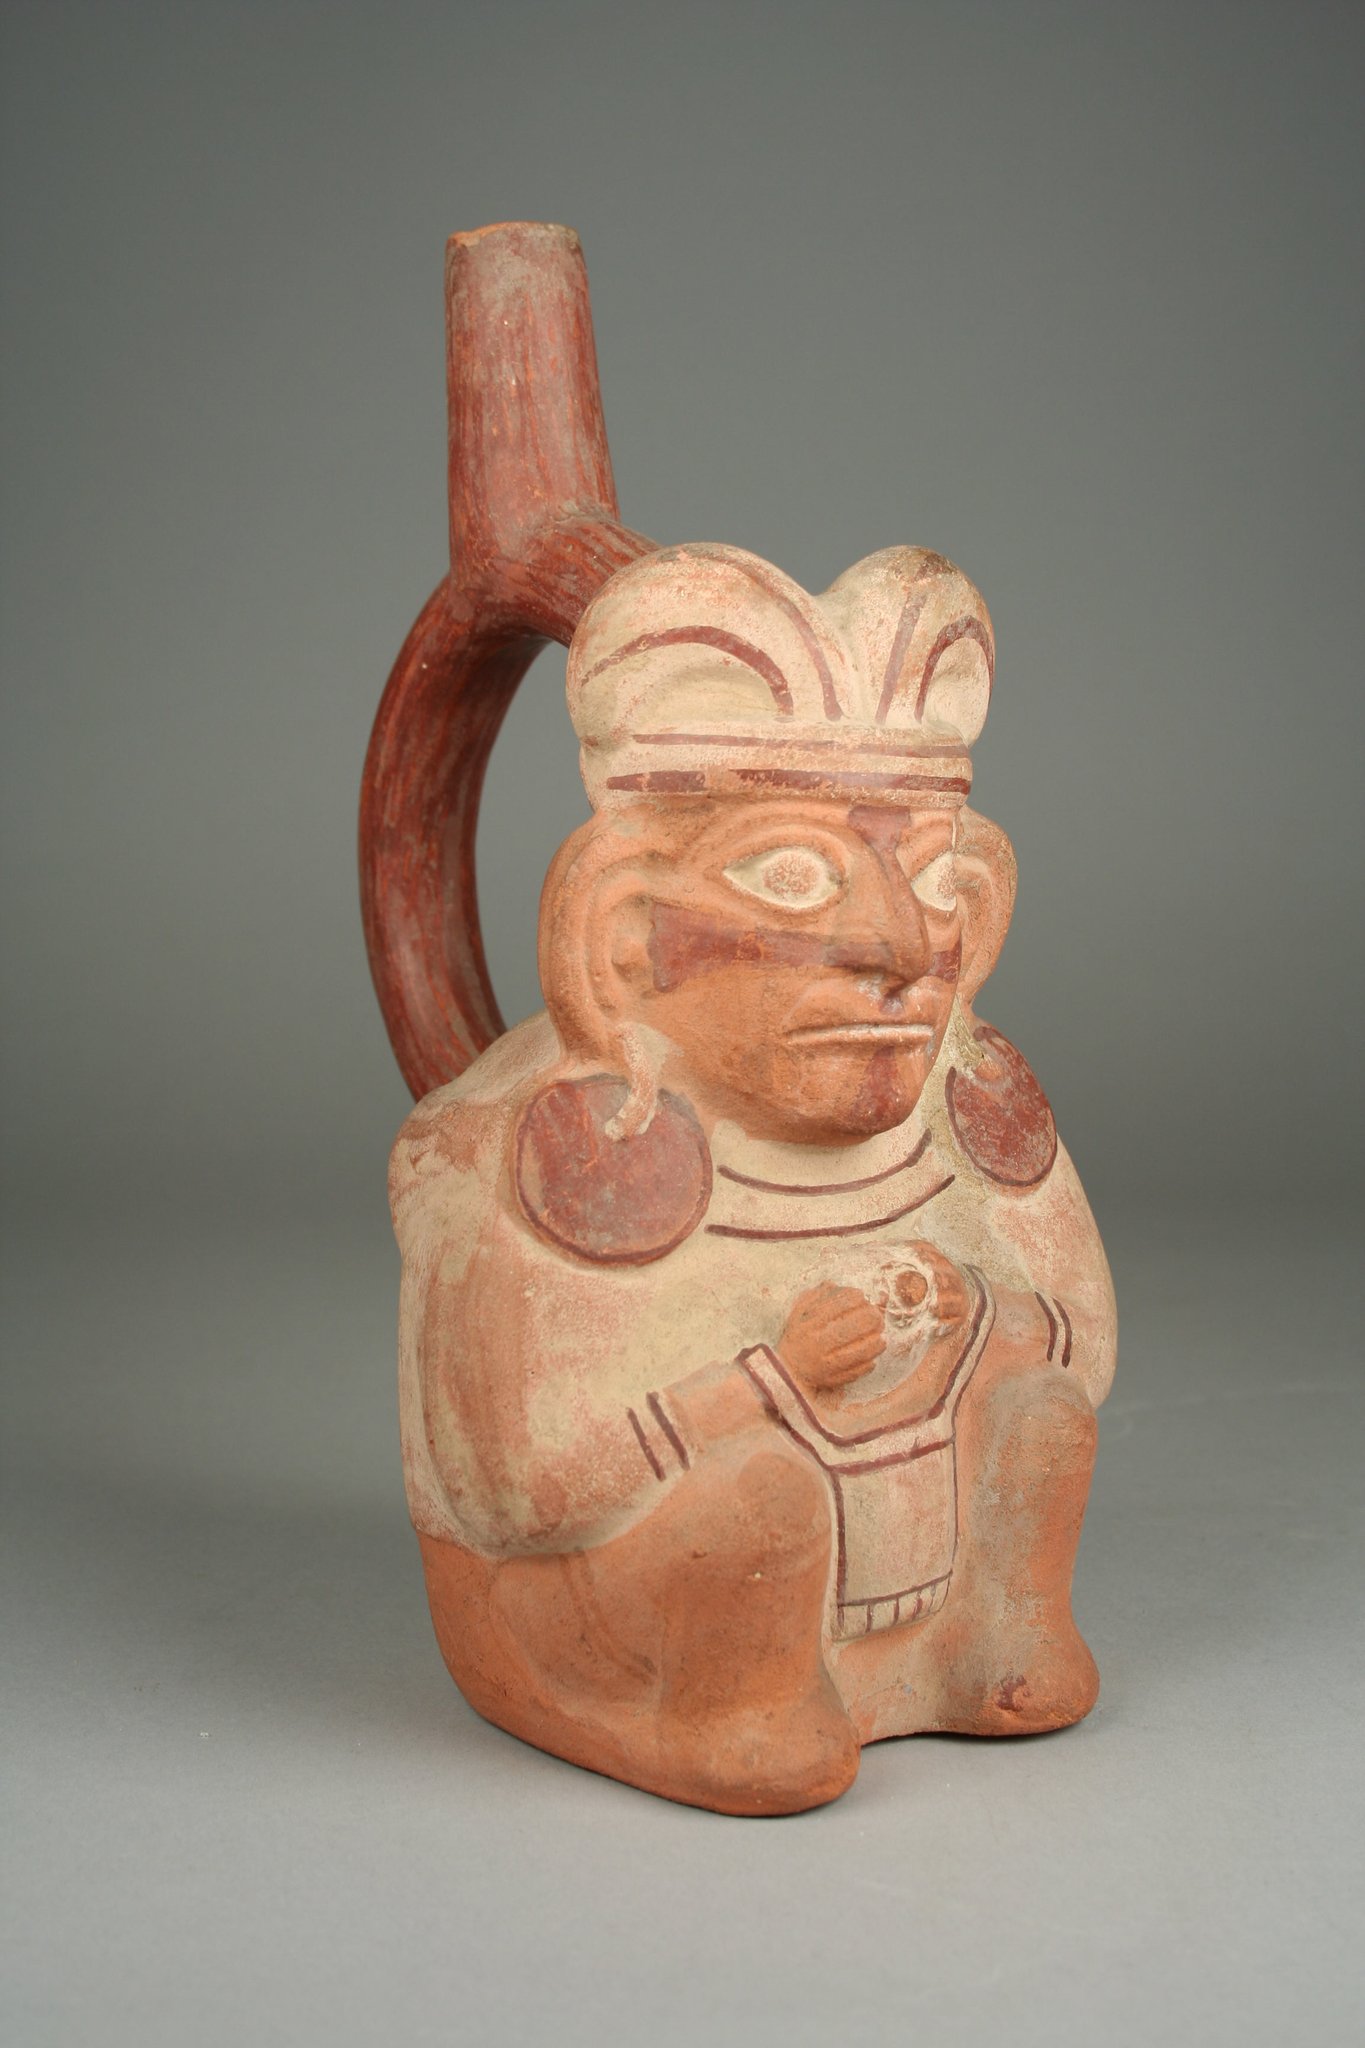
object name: bottle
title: Stirrup Spout Bottle with Seated Figure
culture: moche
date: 401-700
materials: ceramic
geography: peru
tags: human figures